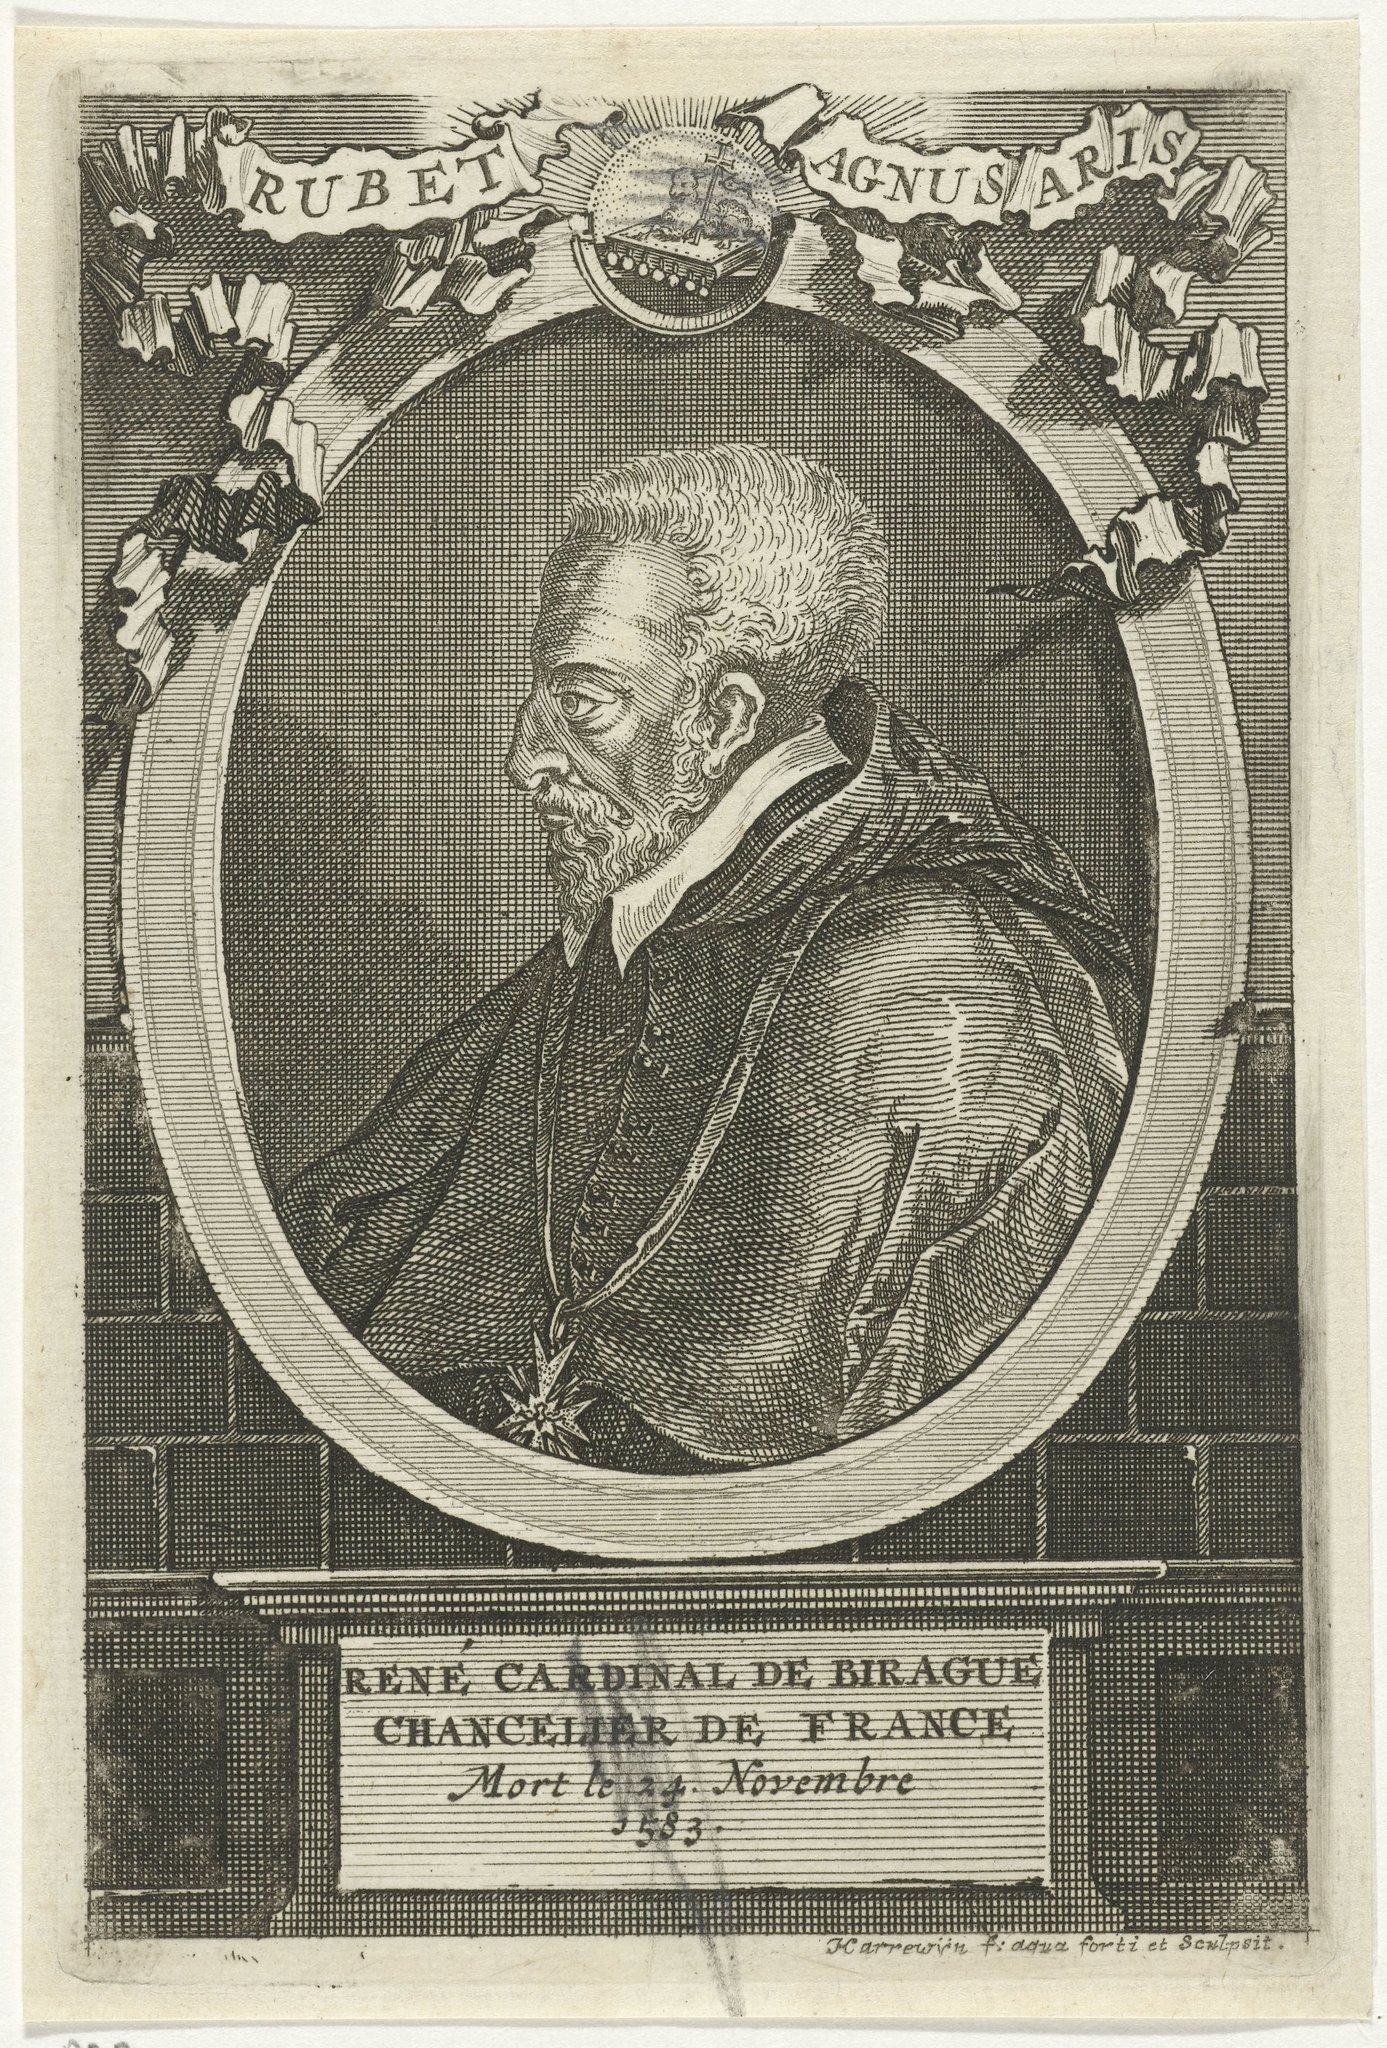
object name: print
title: Portret van Rene de Birague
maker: jacobus harrewijn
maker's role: print maker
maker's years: 1660-1740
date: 1682-1730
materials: paper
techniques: engraving, etching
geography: low countries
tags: rené de birague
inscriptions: collector's mark: Lugt 2228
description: Buste naar links van Rene de Birague in een ovaal. Boven het portret een afbeelding van het Lam Gods liggend op een boek met de spreuk: Rubet agnus aris. Onder het portret vier regels in het Frans.